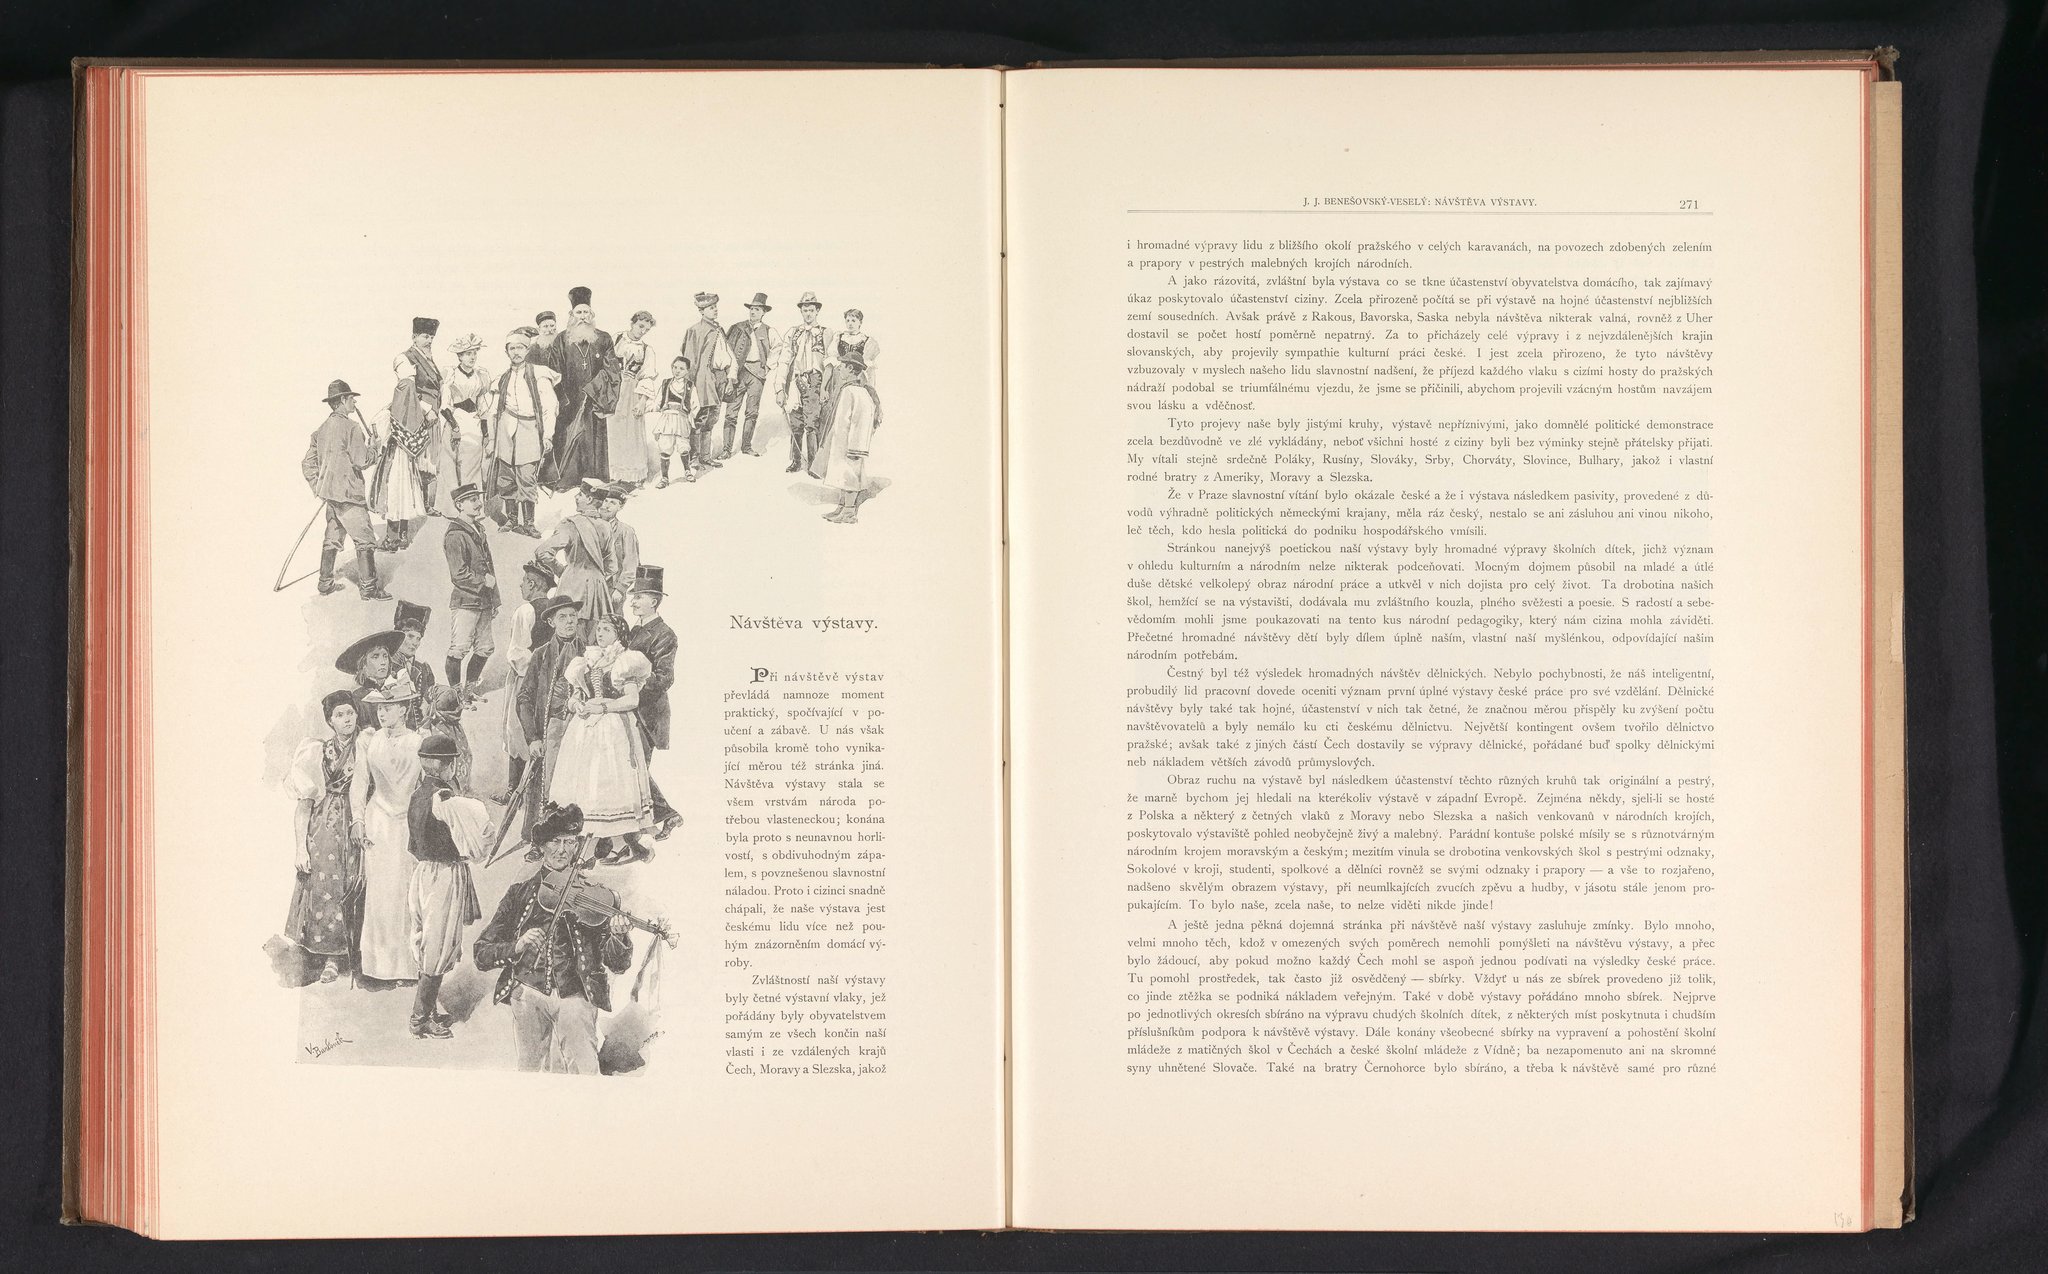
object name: photomechanical print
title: Fotoreproductie van een tekening, voorstellende bezoekers van het Výstaviště te Praag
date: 1891-1893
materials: paper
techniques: autotype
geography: prague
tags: anonymous historical persons portrayed in a group, in a group-portrait